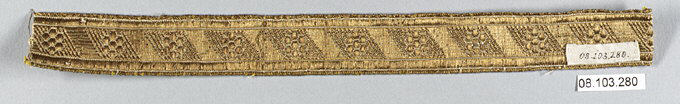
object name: galloon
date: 1601-1800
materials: metal thread